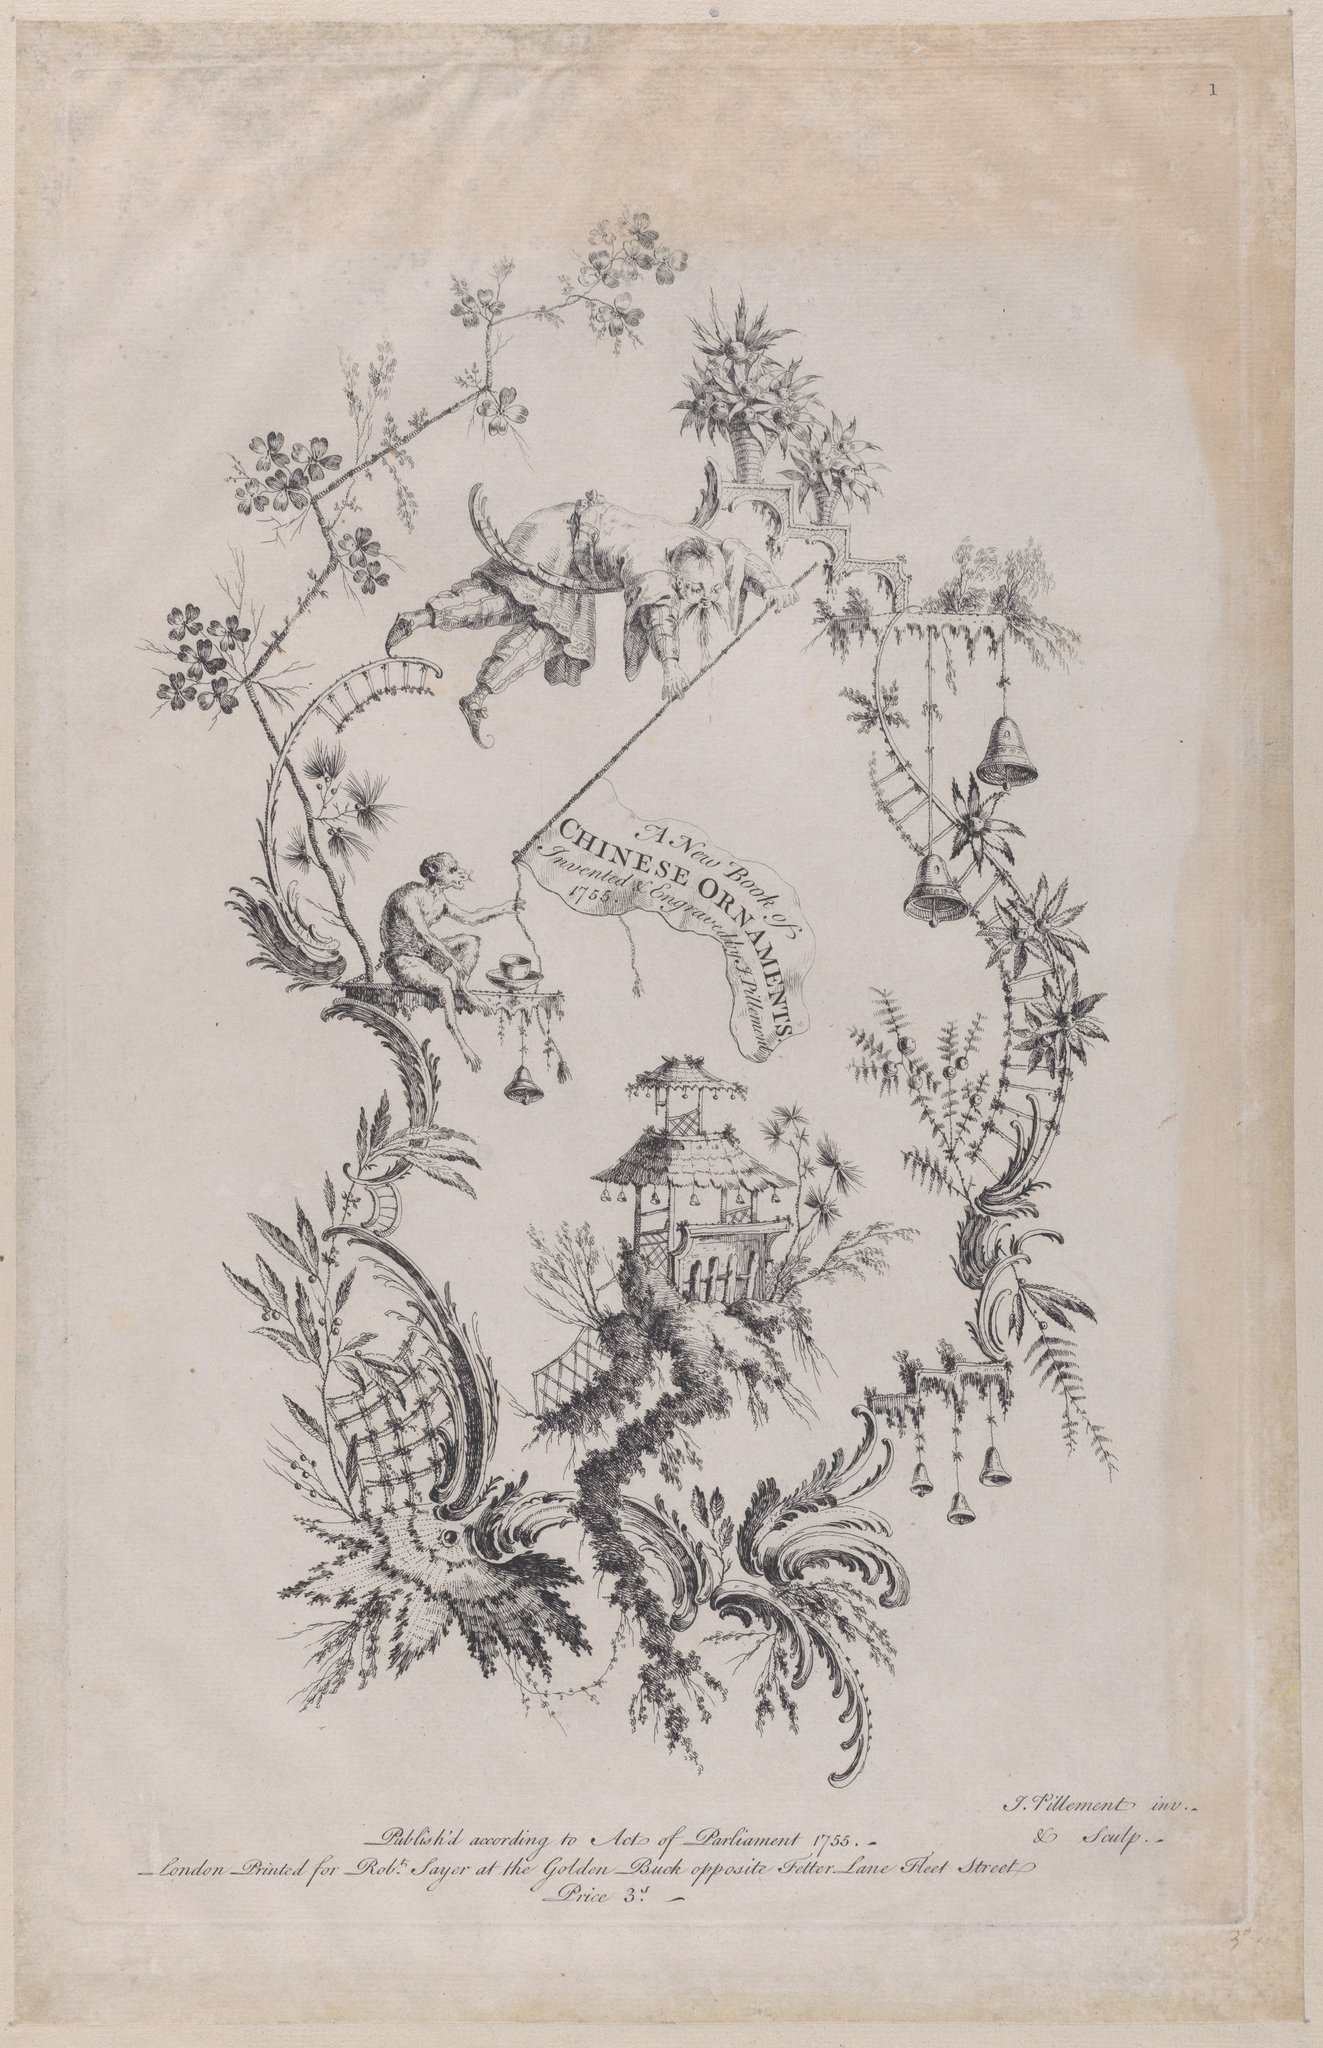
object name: print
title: Title page to "A New Book of Chinese Ornaments"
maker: jean pillement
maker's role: artist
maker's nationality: french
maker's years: 1728-1808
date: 1755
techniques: etching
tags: chinoiserie,ornament